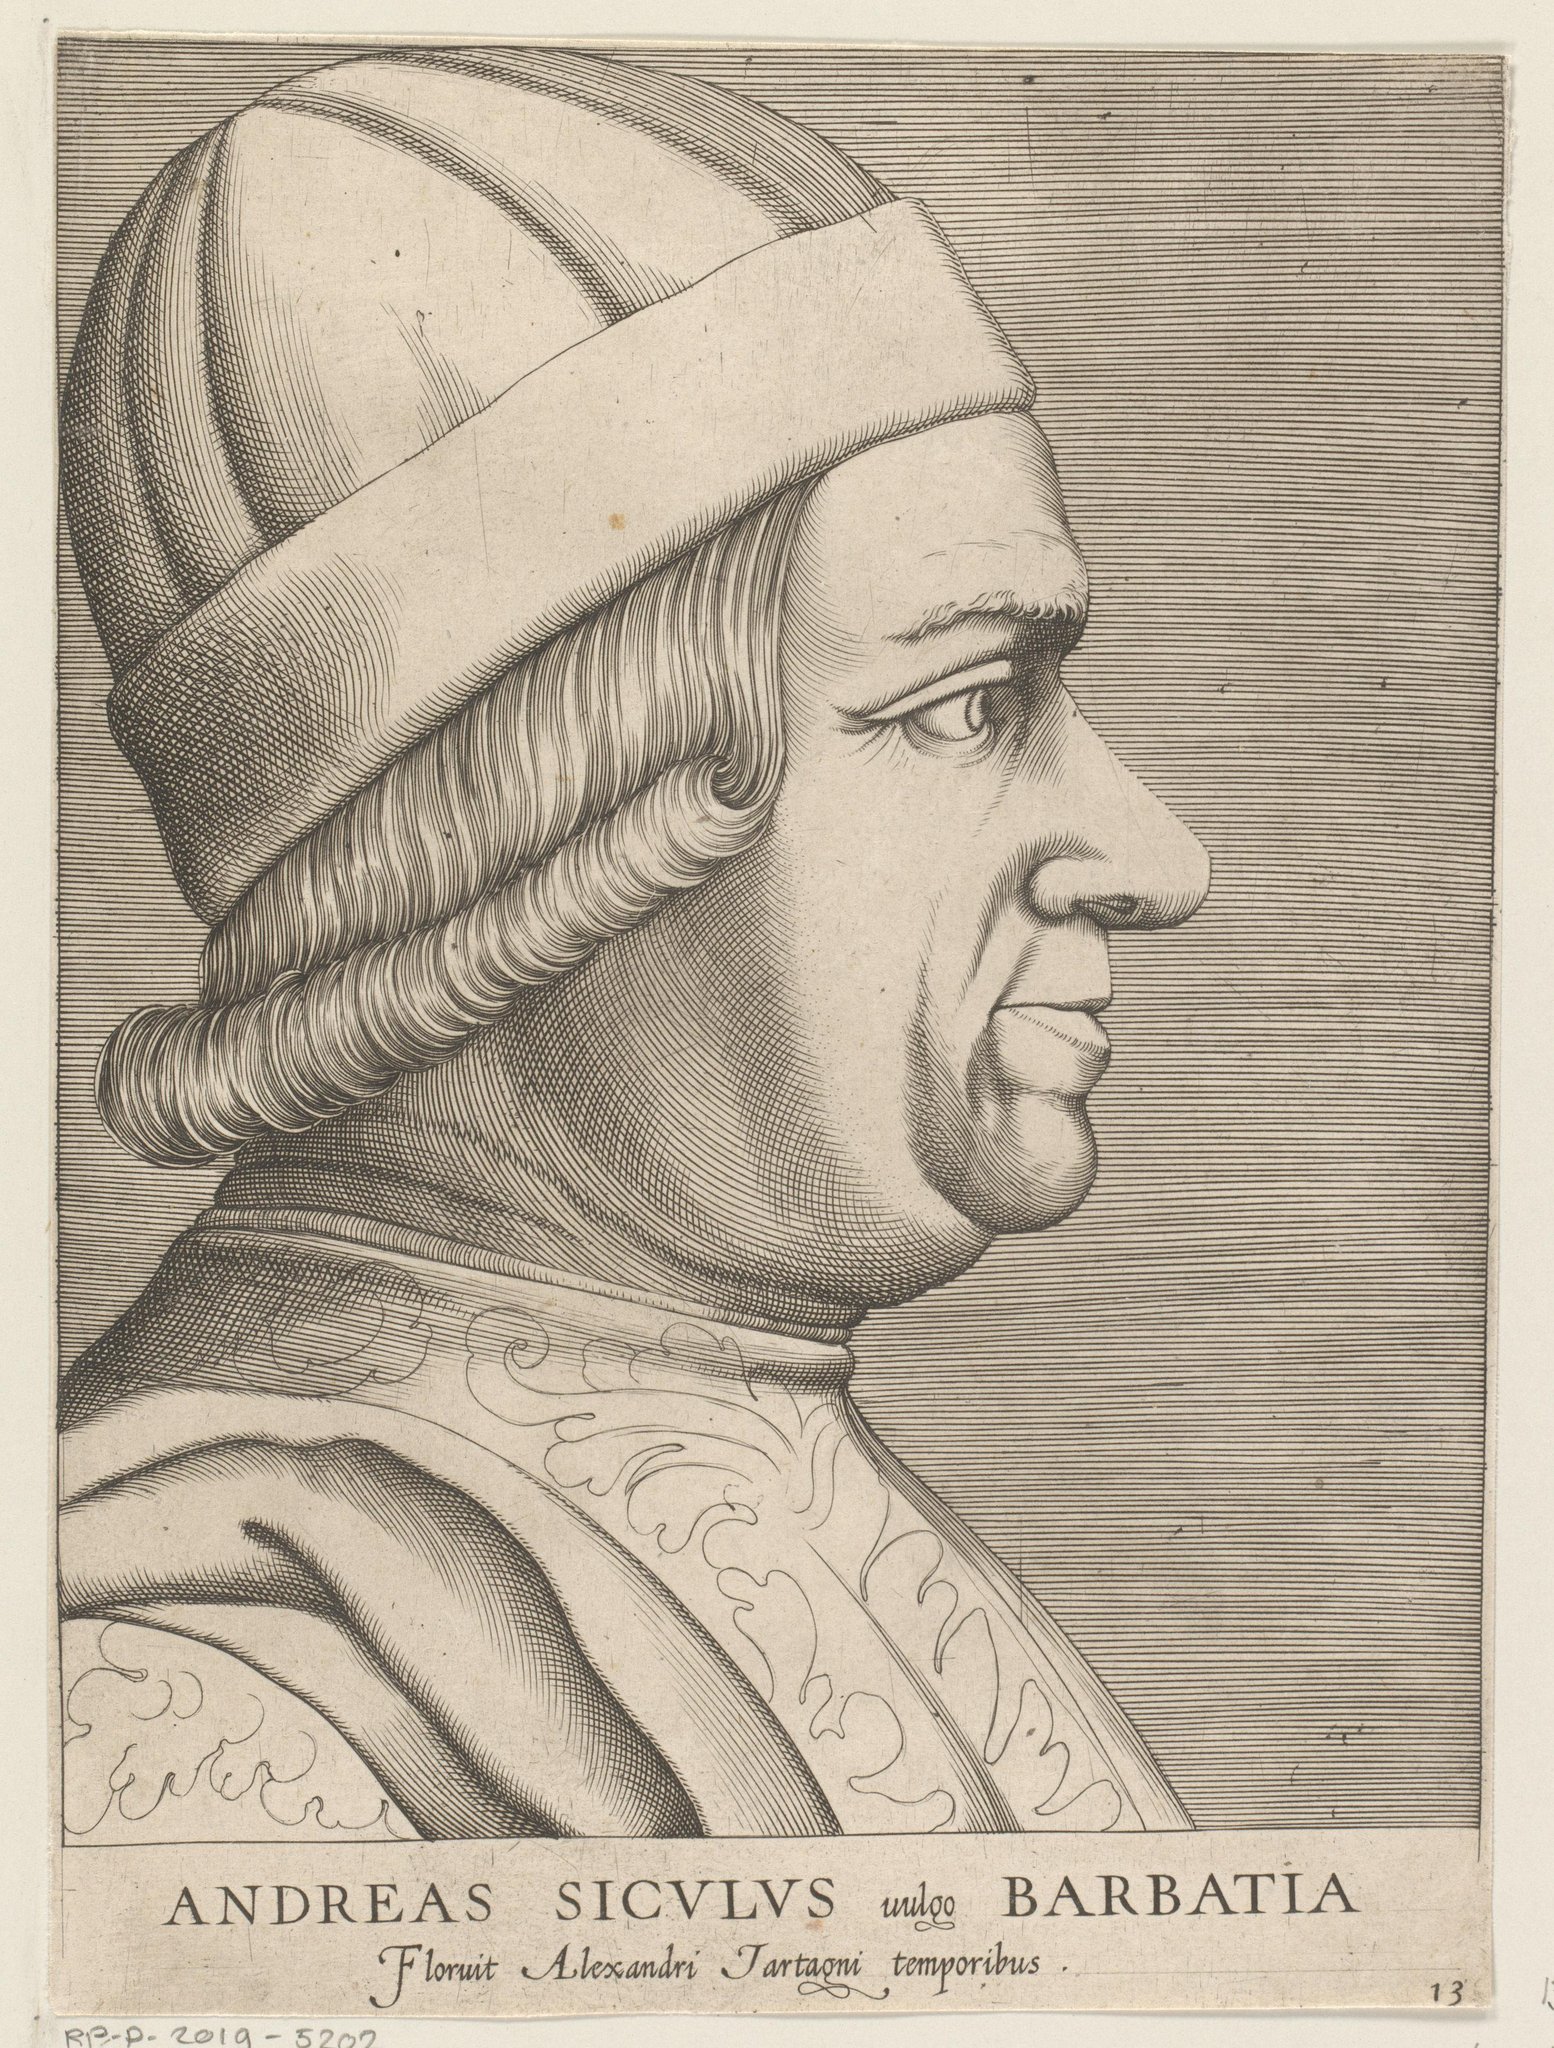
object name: print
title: Portretten van nobele juristen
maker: Anonymous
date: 1566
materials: paper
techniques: engraving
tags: historical persons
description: Prentserie voor het eerst uitgegeven te Rome door Antonio Lafreri in 1566. Serie waarschijnlijk opnieuw uitgegeven door Petri de' Nobili rond 1584-1585.